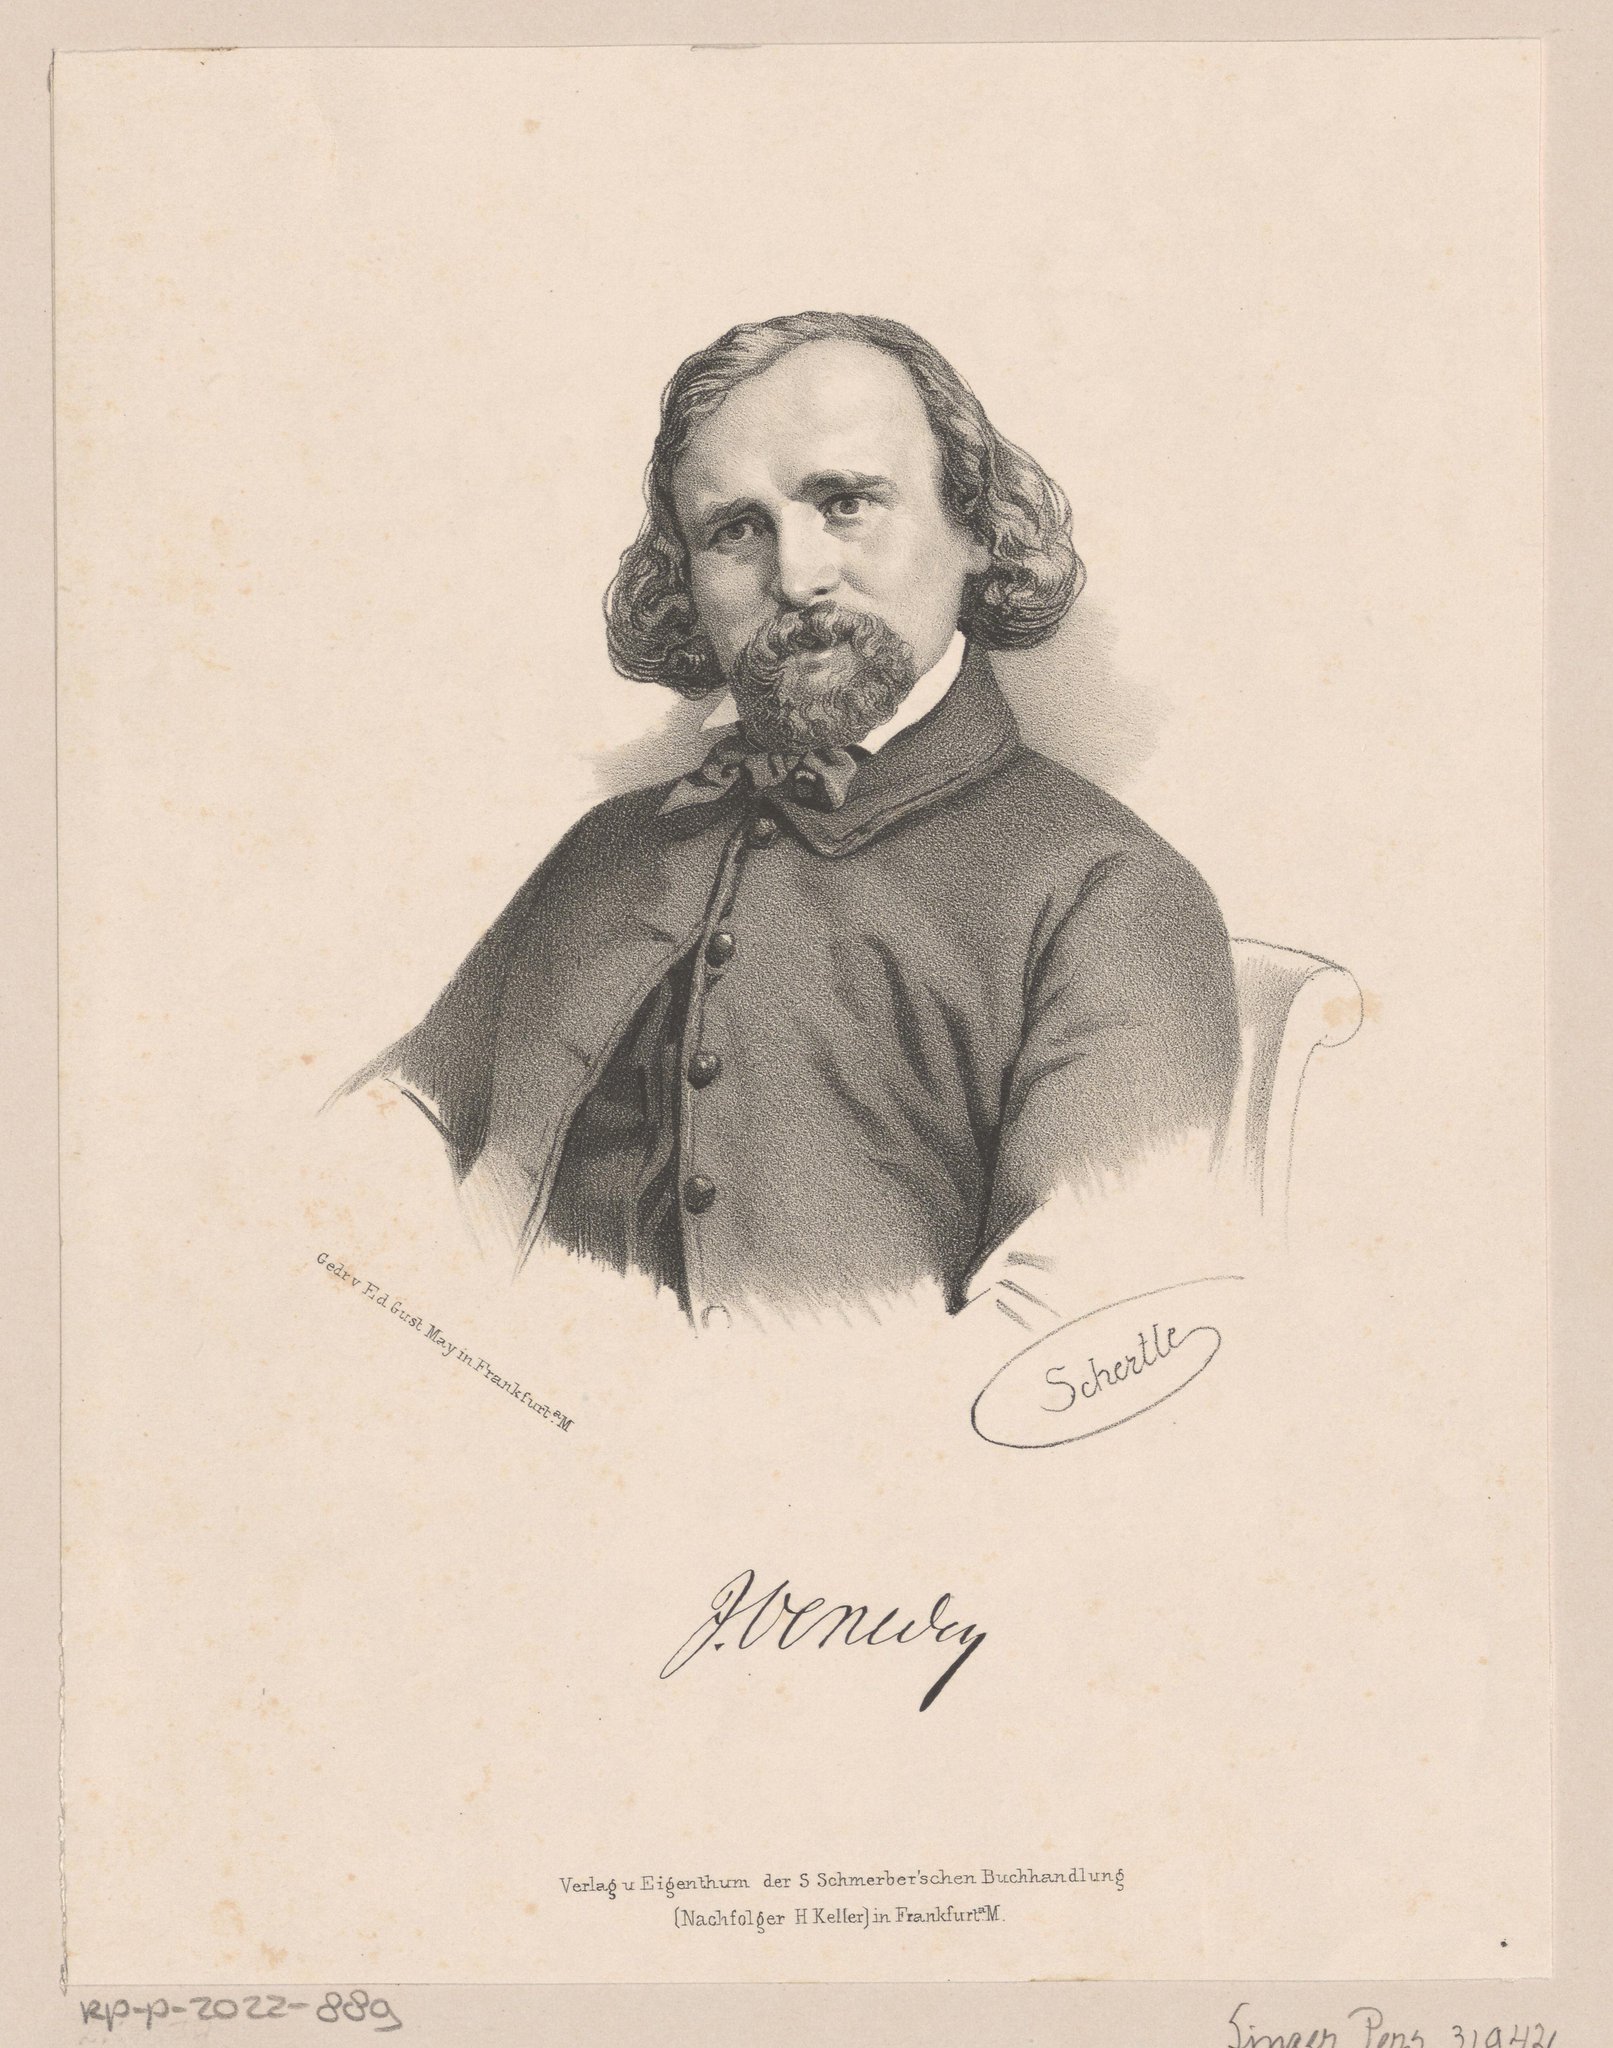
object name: print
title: Die Männer des deutschen Volks oder Deutsche National-Gallerie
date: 1848-1849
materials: paper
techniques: lithograph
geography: frankfurt am main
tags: cologne, politician, historical persons, portrait of a writer, politician, e.g. party leader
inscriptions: collector's mark: Lugt 2233